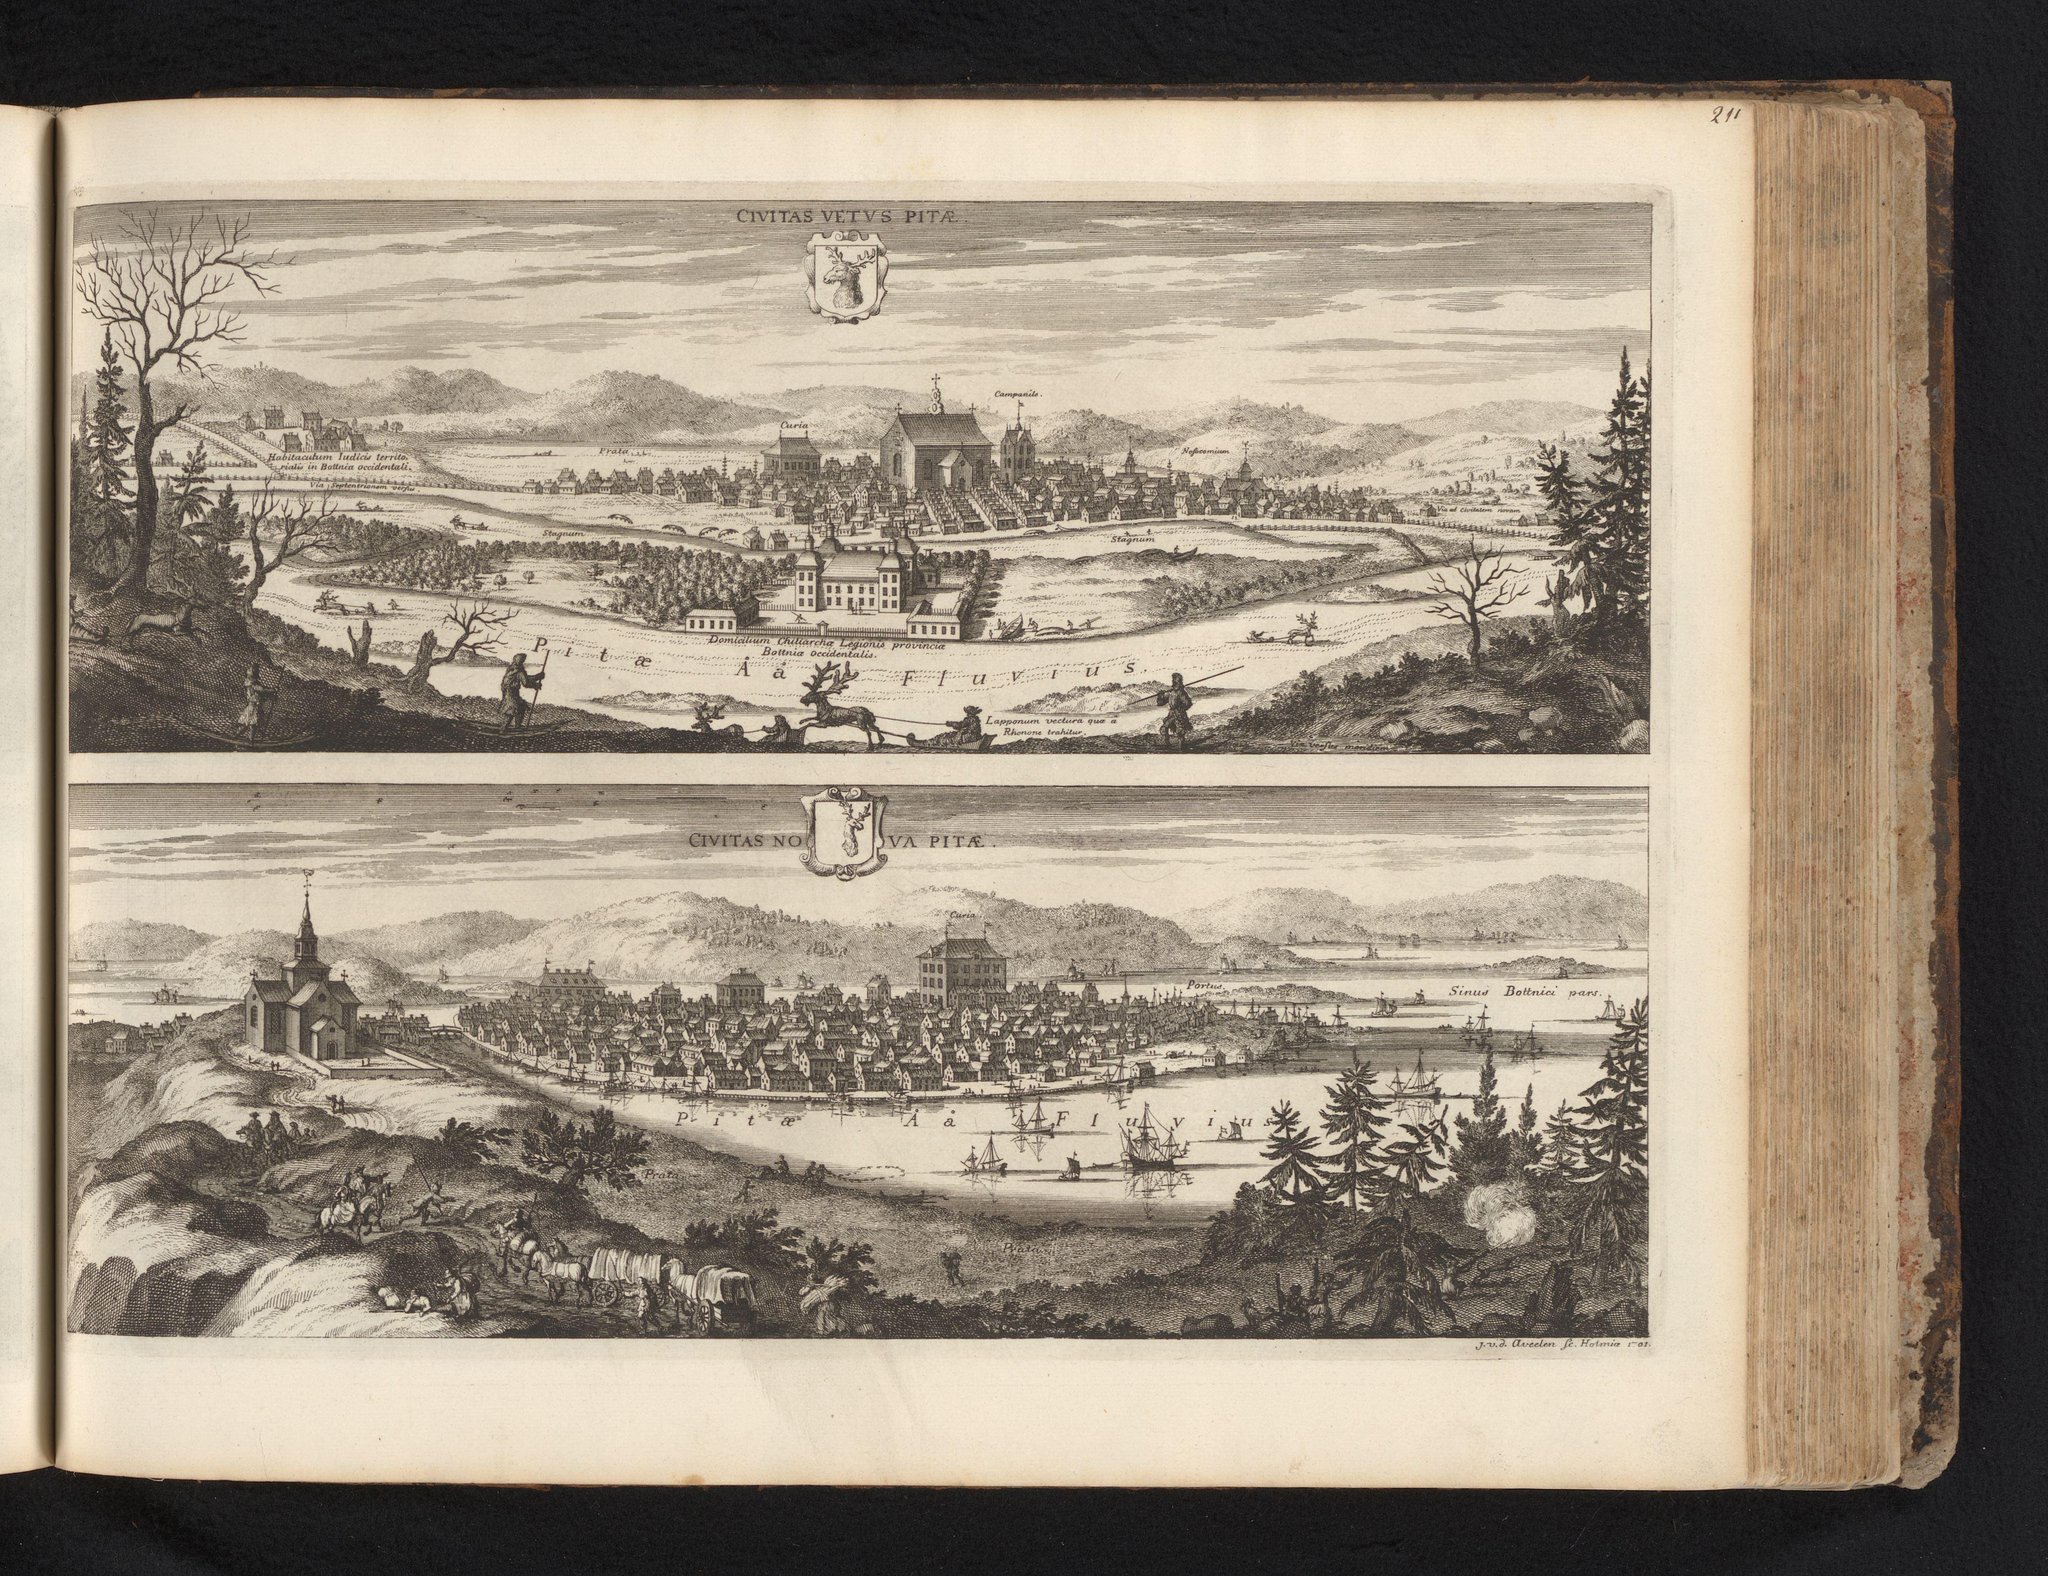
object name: album leaf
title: Gezicht op Piteå, de oude en nieuwe stad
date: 1701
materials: paper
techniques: etching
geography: stockholm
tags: city-view in general; 'veduta'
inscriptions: date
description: Kungliga Biblioteket, 'Suecia': http://www.kb.se/samlingarna/Kartor-bilder/Suecia-antiqua/ (geraadpleegd november 2016).